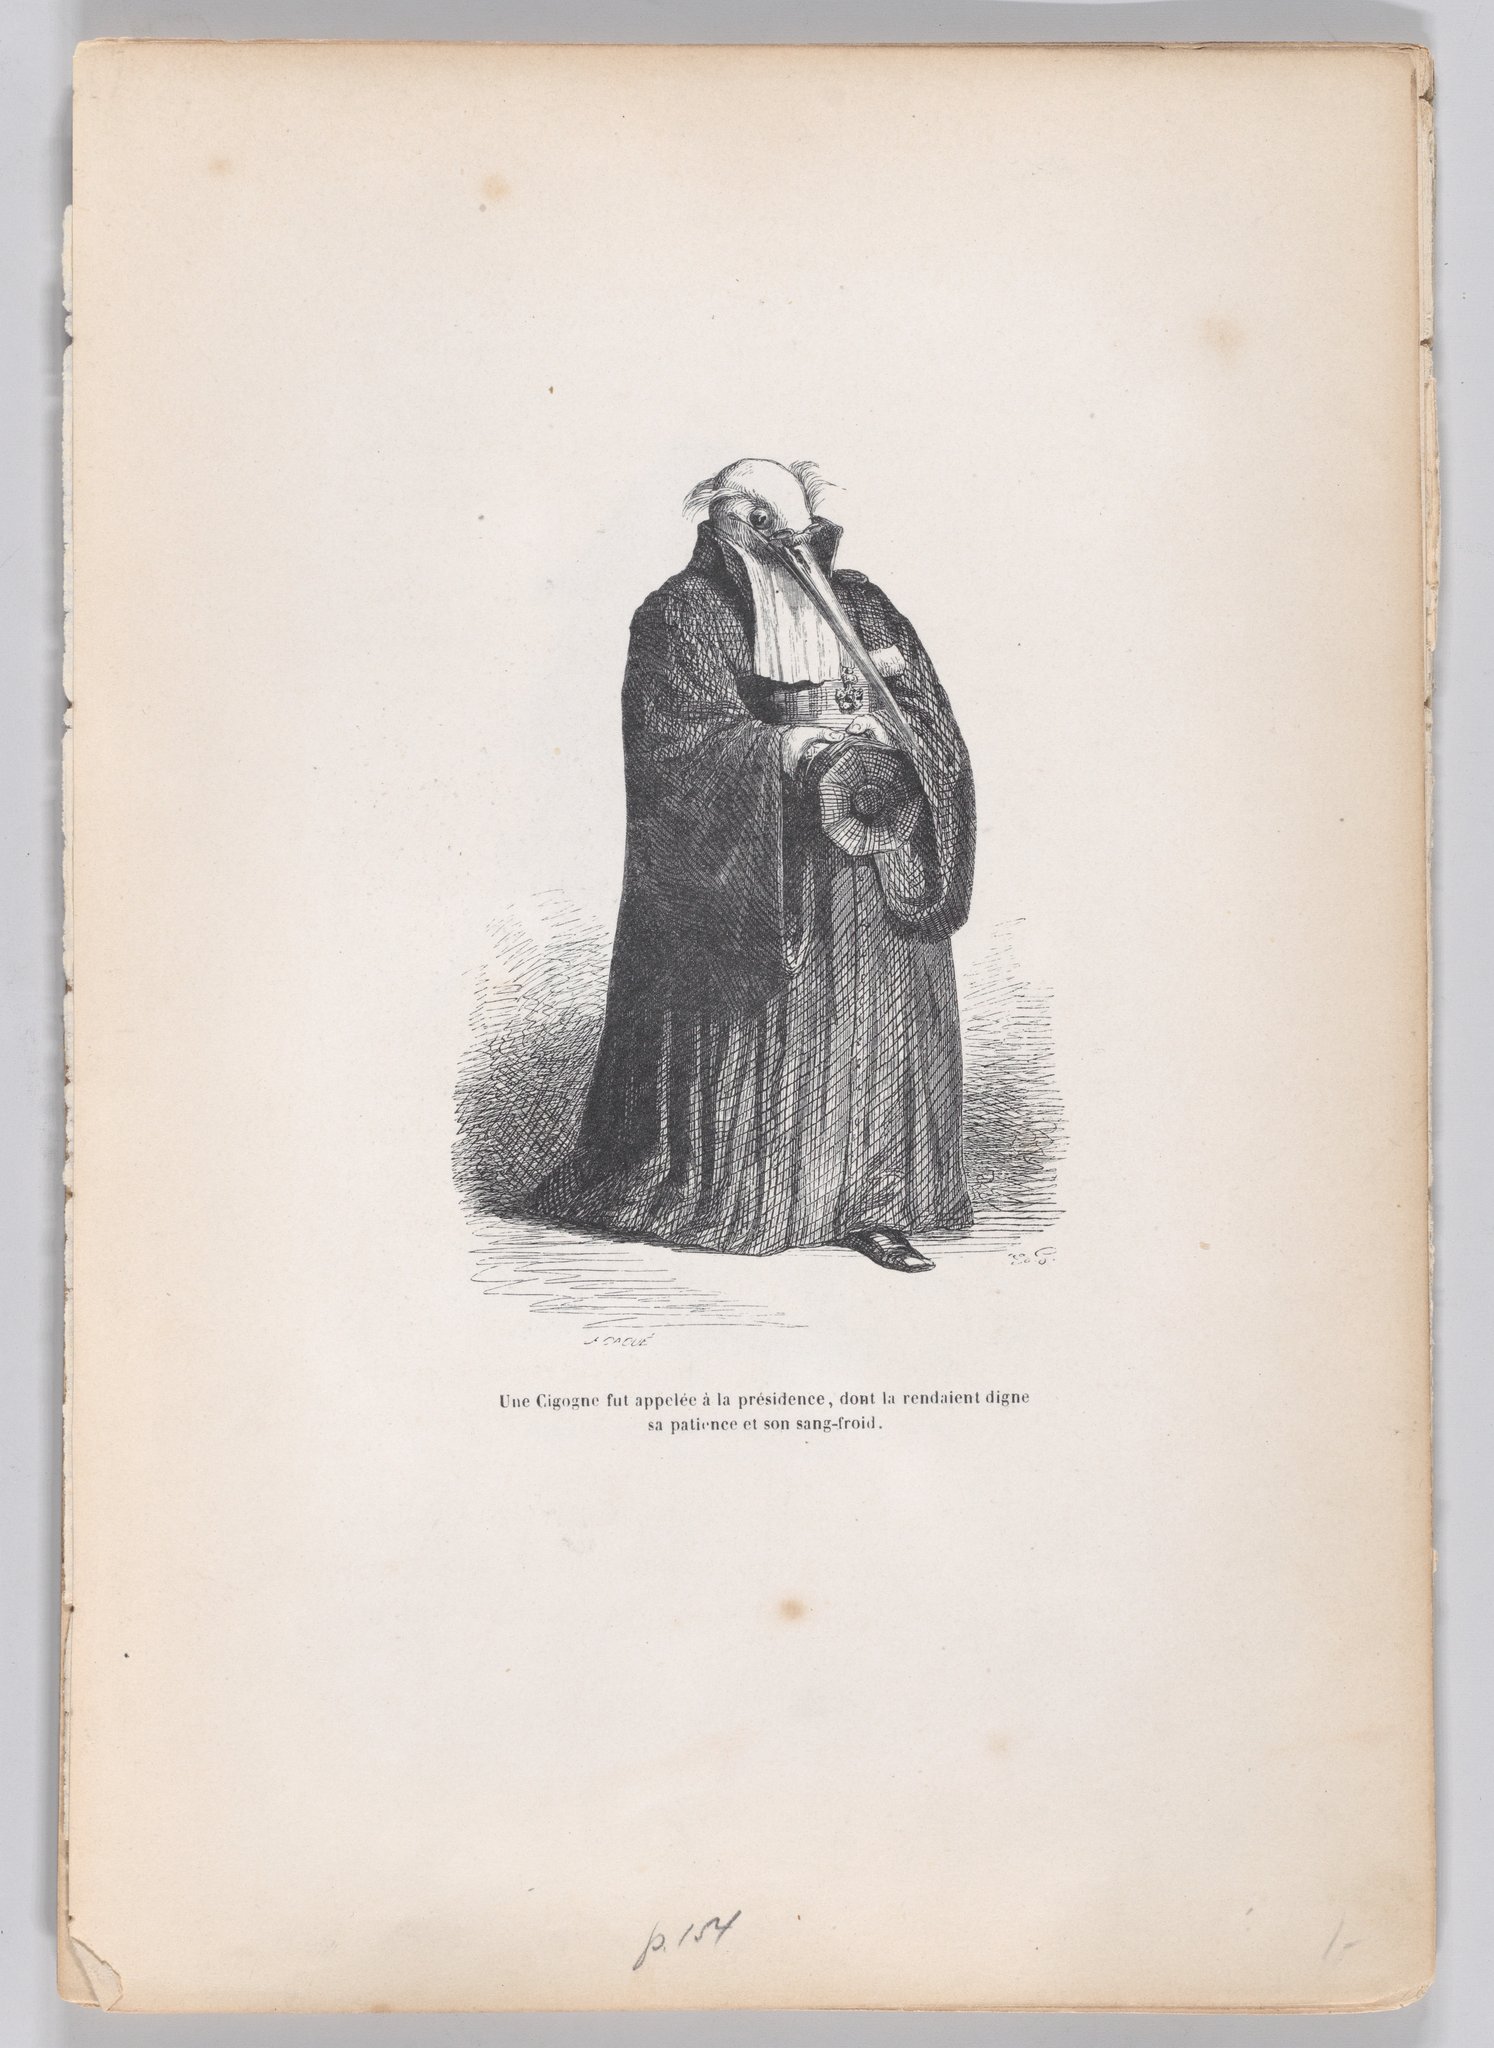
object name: print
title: A Stork was called to the presidency..., from "Scenes from the Private and Public Life of Animals"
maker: j. j. grandville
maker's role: illustrator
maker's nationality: french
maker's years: 1803-1847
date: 1837-1847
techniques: engraving